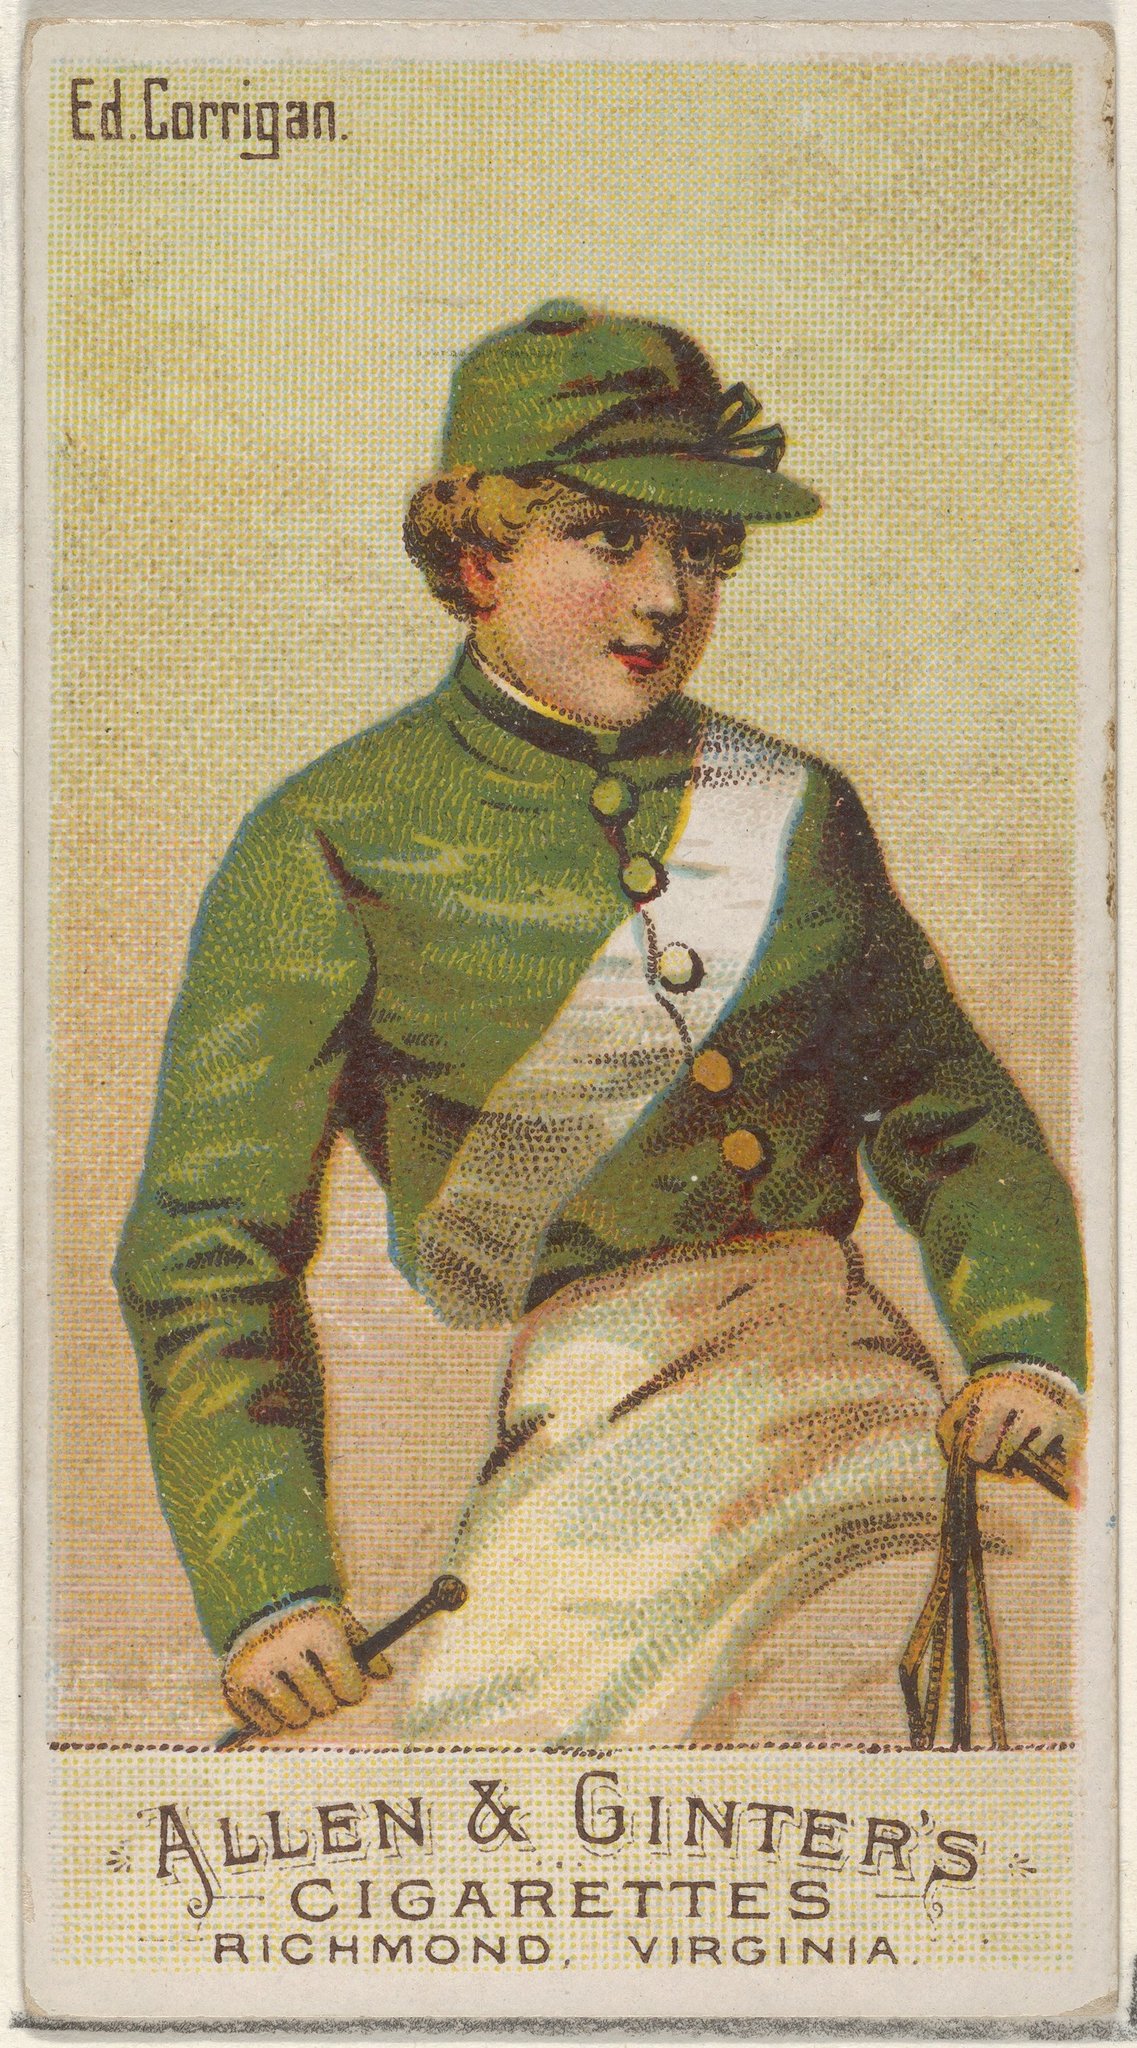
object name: print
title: Edward Corrigan, from the Racing Colors of the World series (N22a) for Allen & Ginter Cigarettes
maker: allen & ginter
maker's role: publisher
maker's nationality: american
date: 1888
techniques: color lithograph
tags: men,jockeys